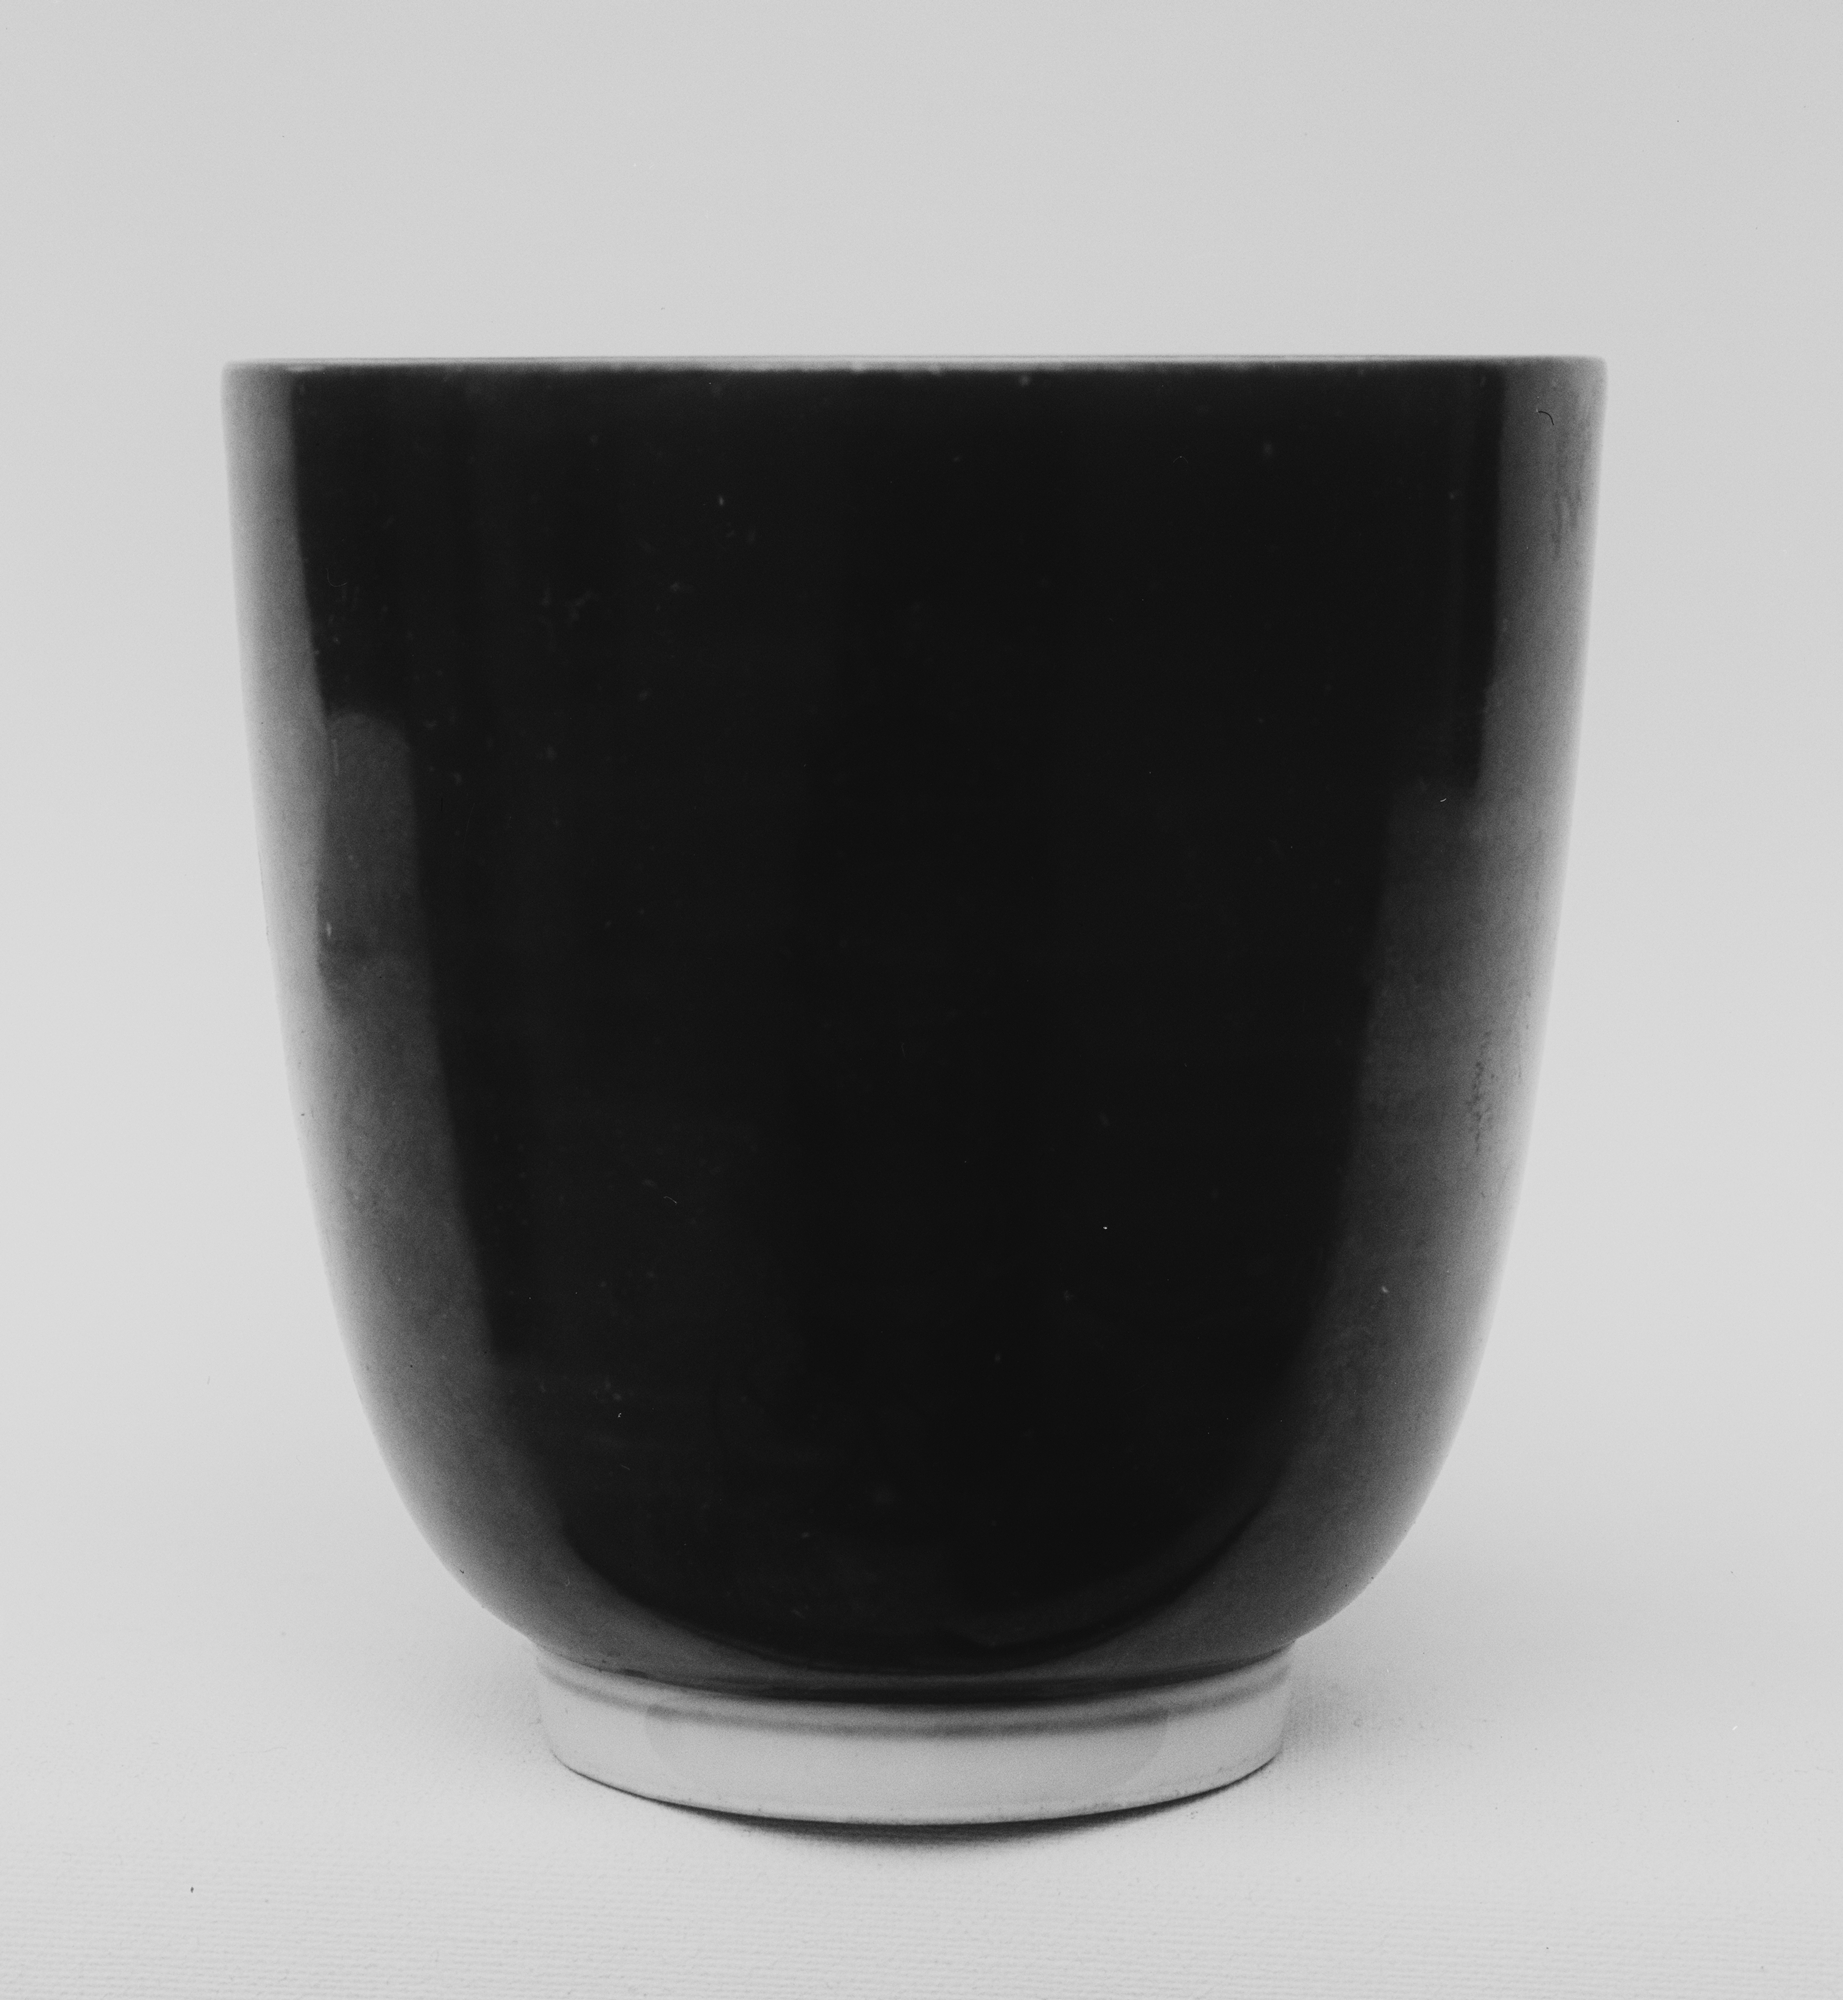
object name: bowl, deep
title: Deep Bowl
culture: japanese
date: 1800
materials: glaze, porcelain